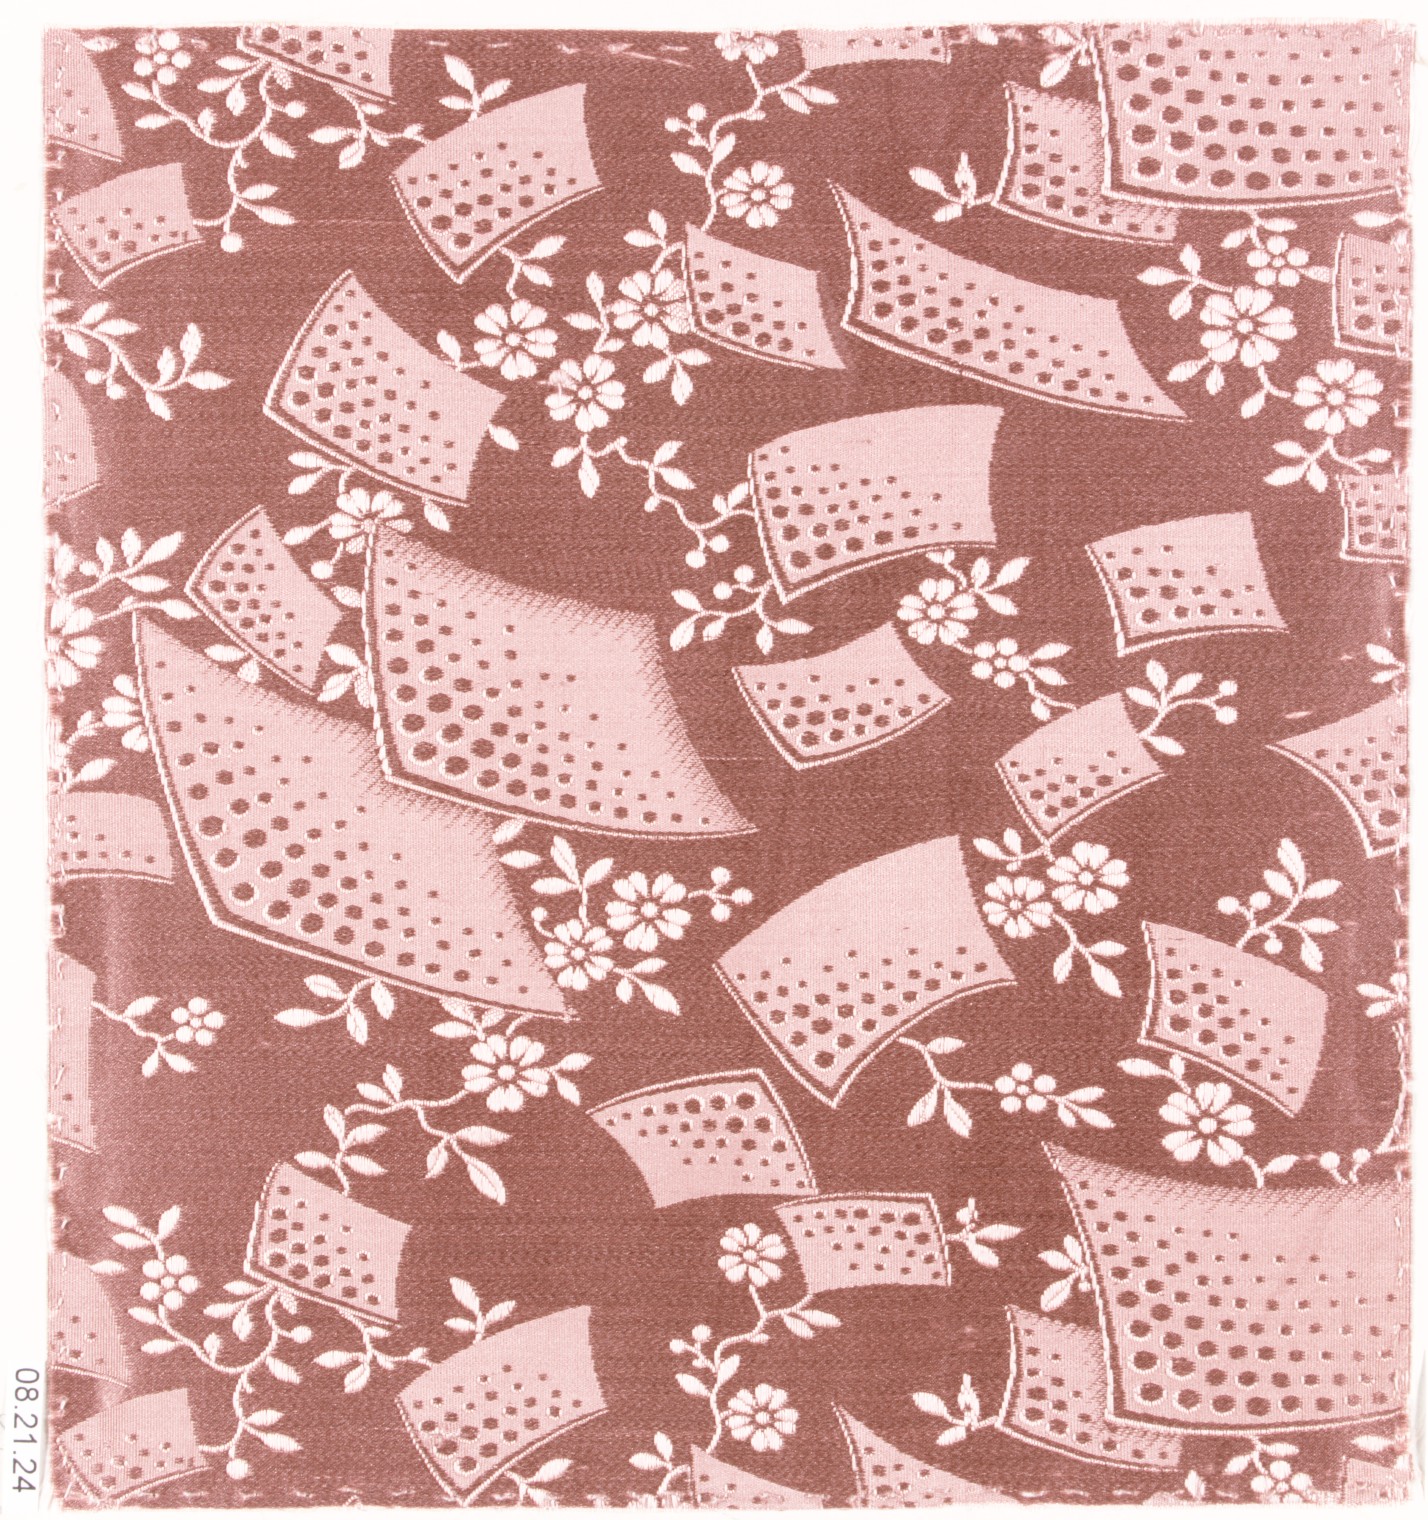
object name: textile sample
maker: Anonymous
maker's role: designer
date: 1900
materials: silk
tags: flowers